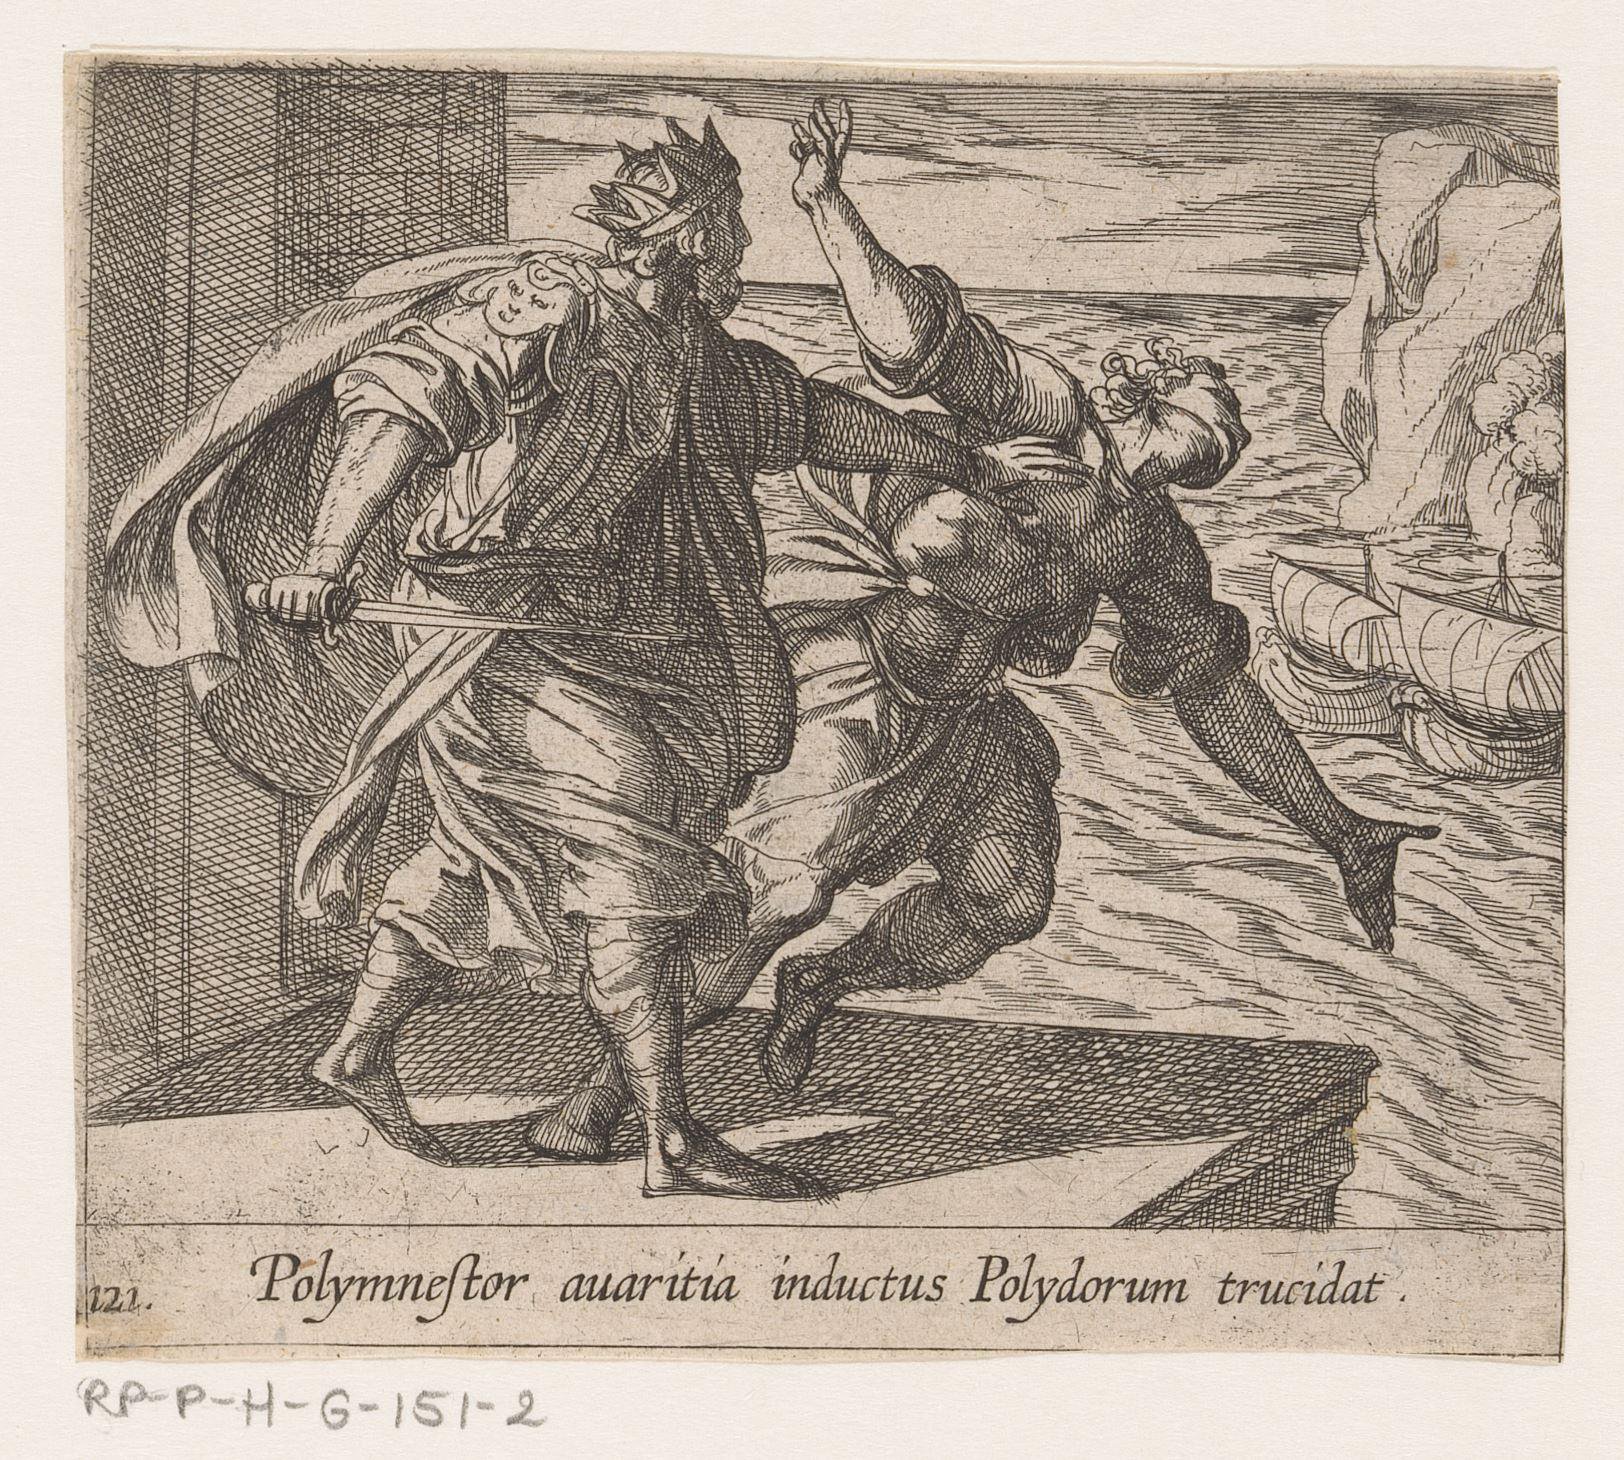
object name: print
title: Metamorphoseon sive transformationum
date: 1606-1638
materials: paper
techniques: etching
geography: amsterdam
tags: polymnestor kills polydorus and throws him into the water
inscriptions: collector's mark: ‘Hinloopen’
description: Deze prent maakt deel uit van een reeks van 150 prenten (+ titelprent) met voorstellingen van de Metamorfosen van Ovidius.